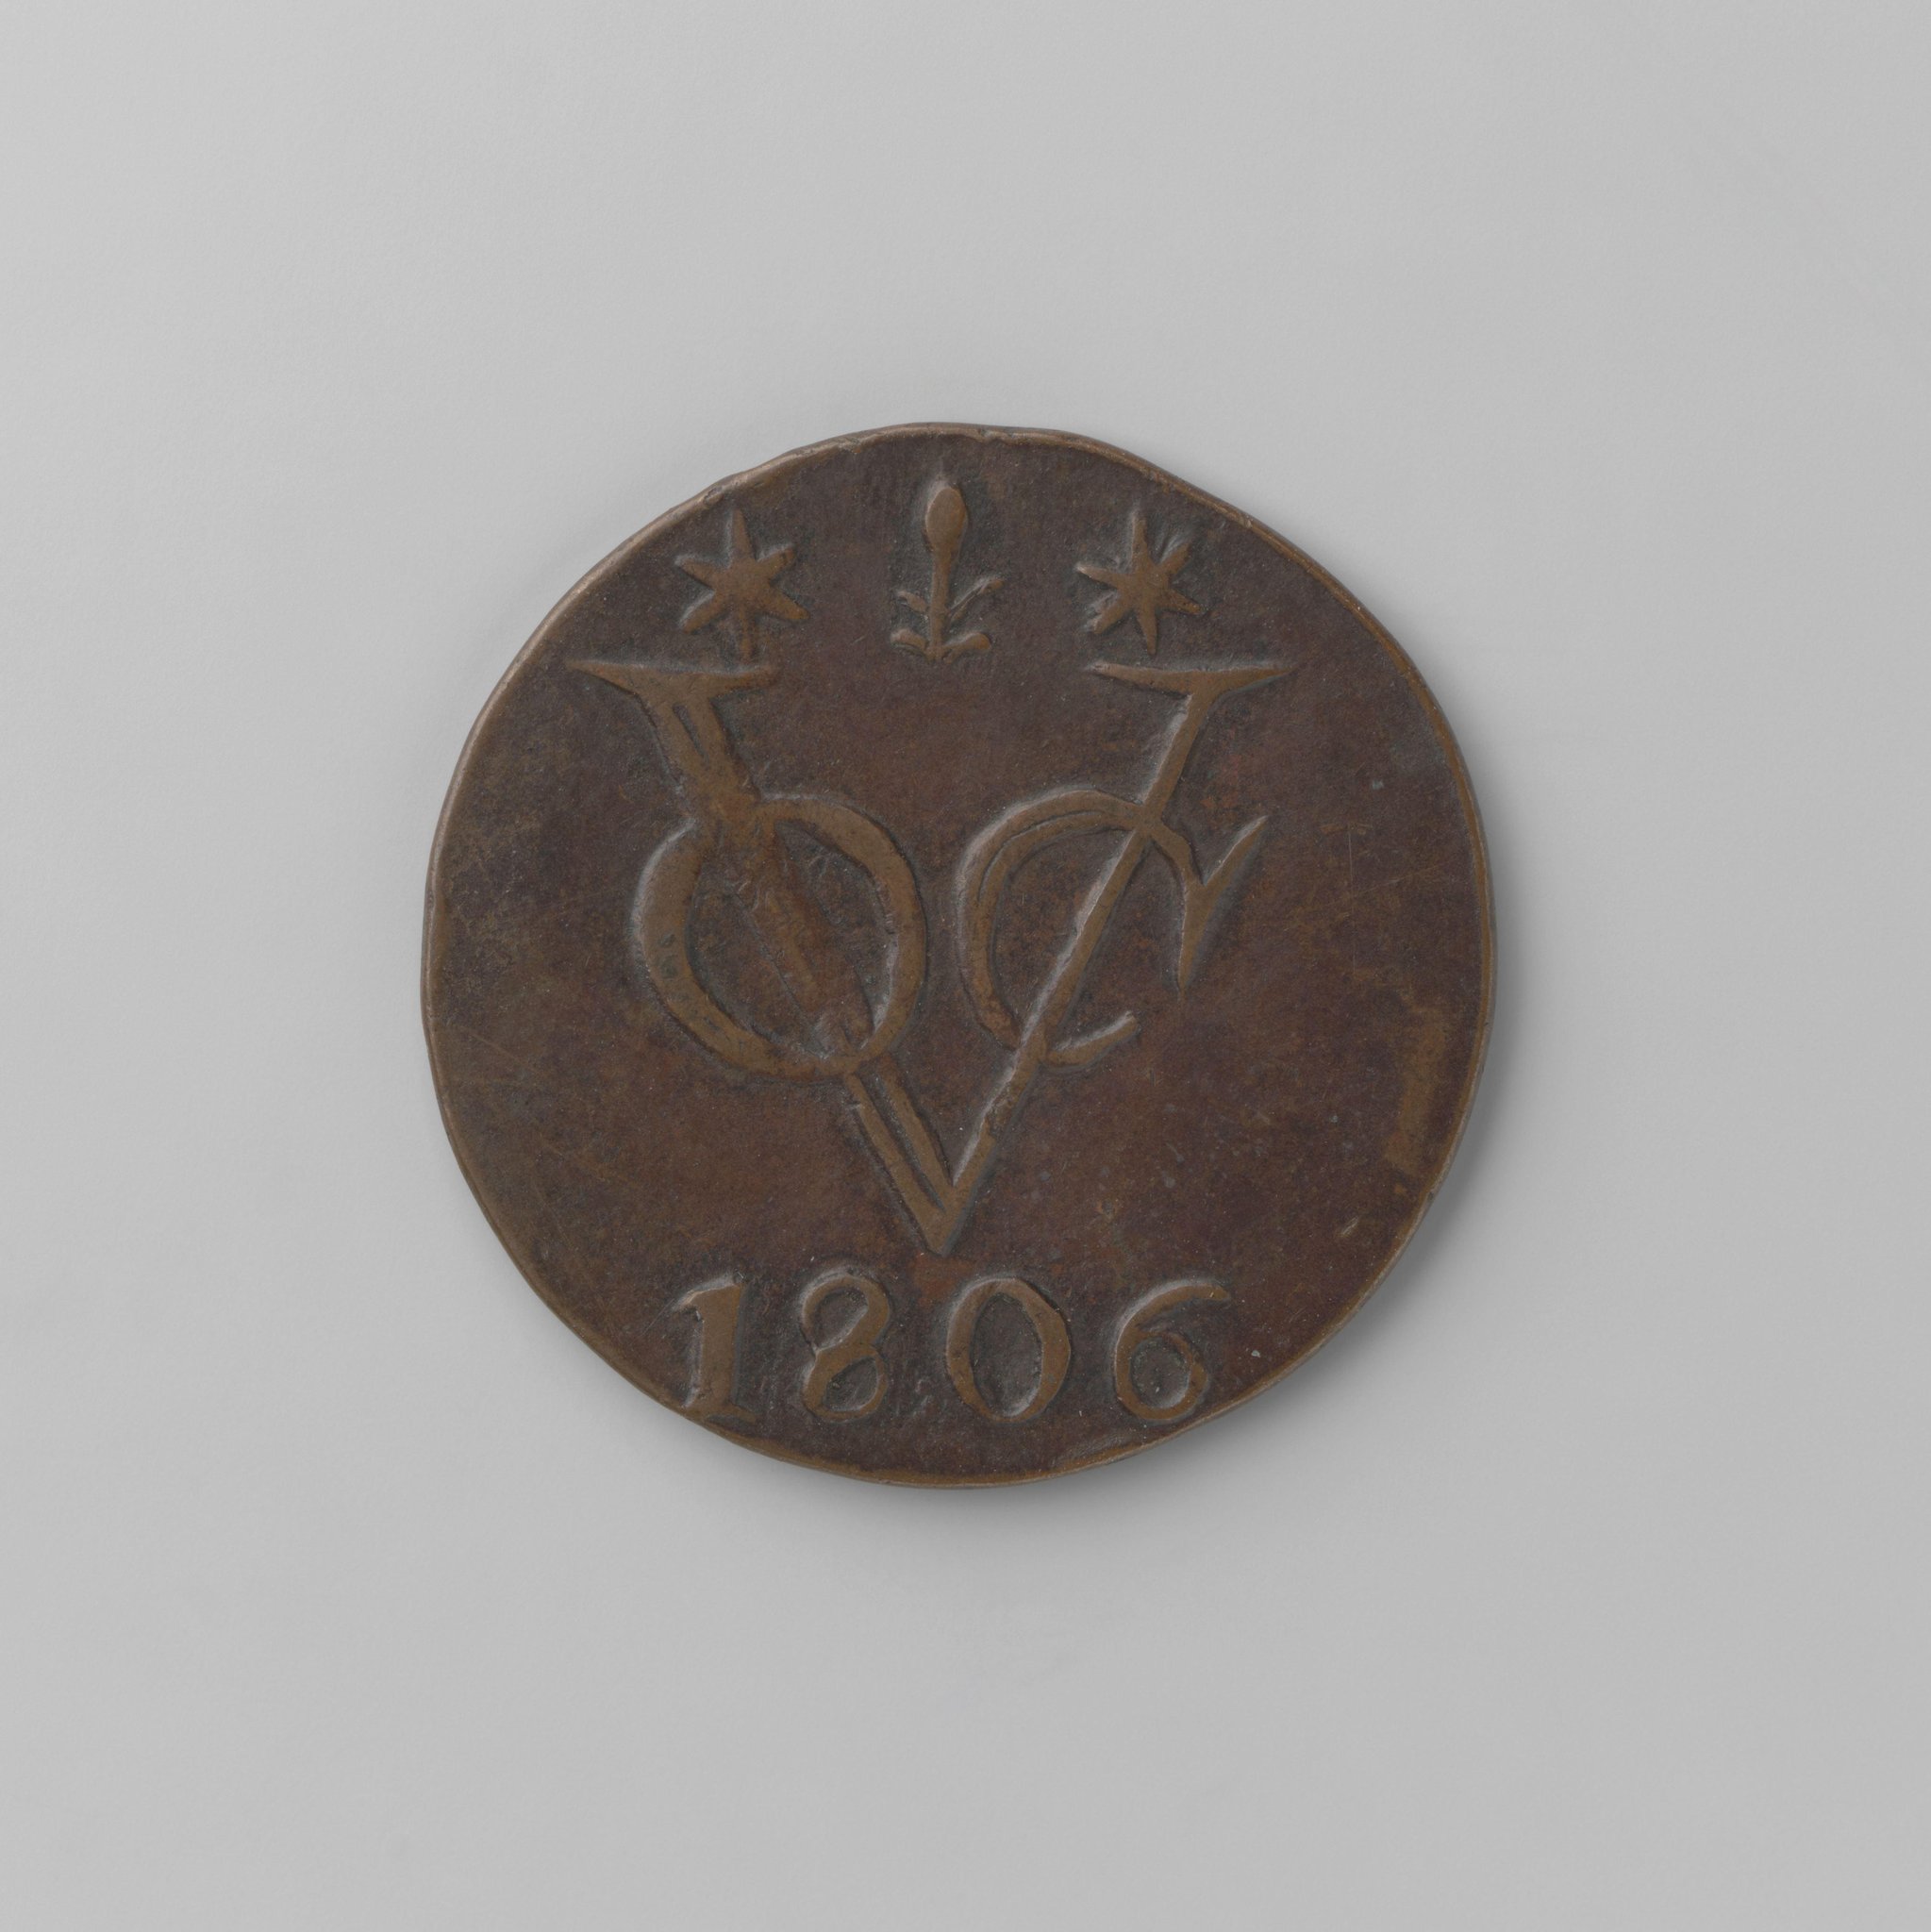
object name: coin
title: Duit voor Nederlands Indië uit Gelderland,1806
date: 1806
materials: copper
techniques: striking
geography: harderwijk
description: Koperen munt. Voorzijde: tussen wapenspreuk gekroond wapenschild van Gelderland. Keerzijde: monogram van de VOC, waarboven muntmeesterteken en waaronder jaartal. Gladde rand.